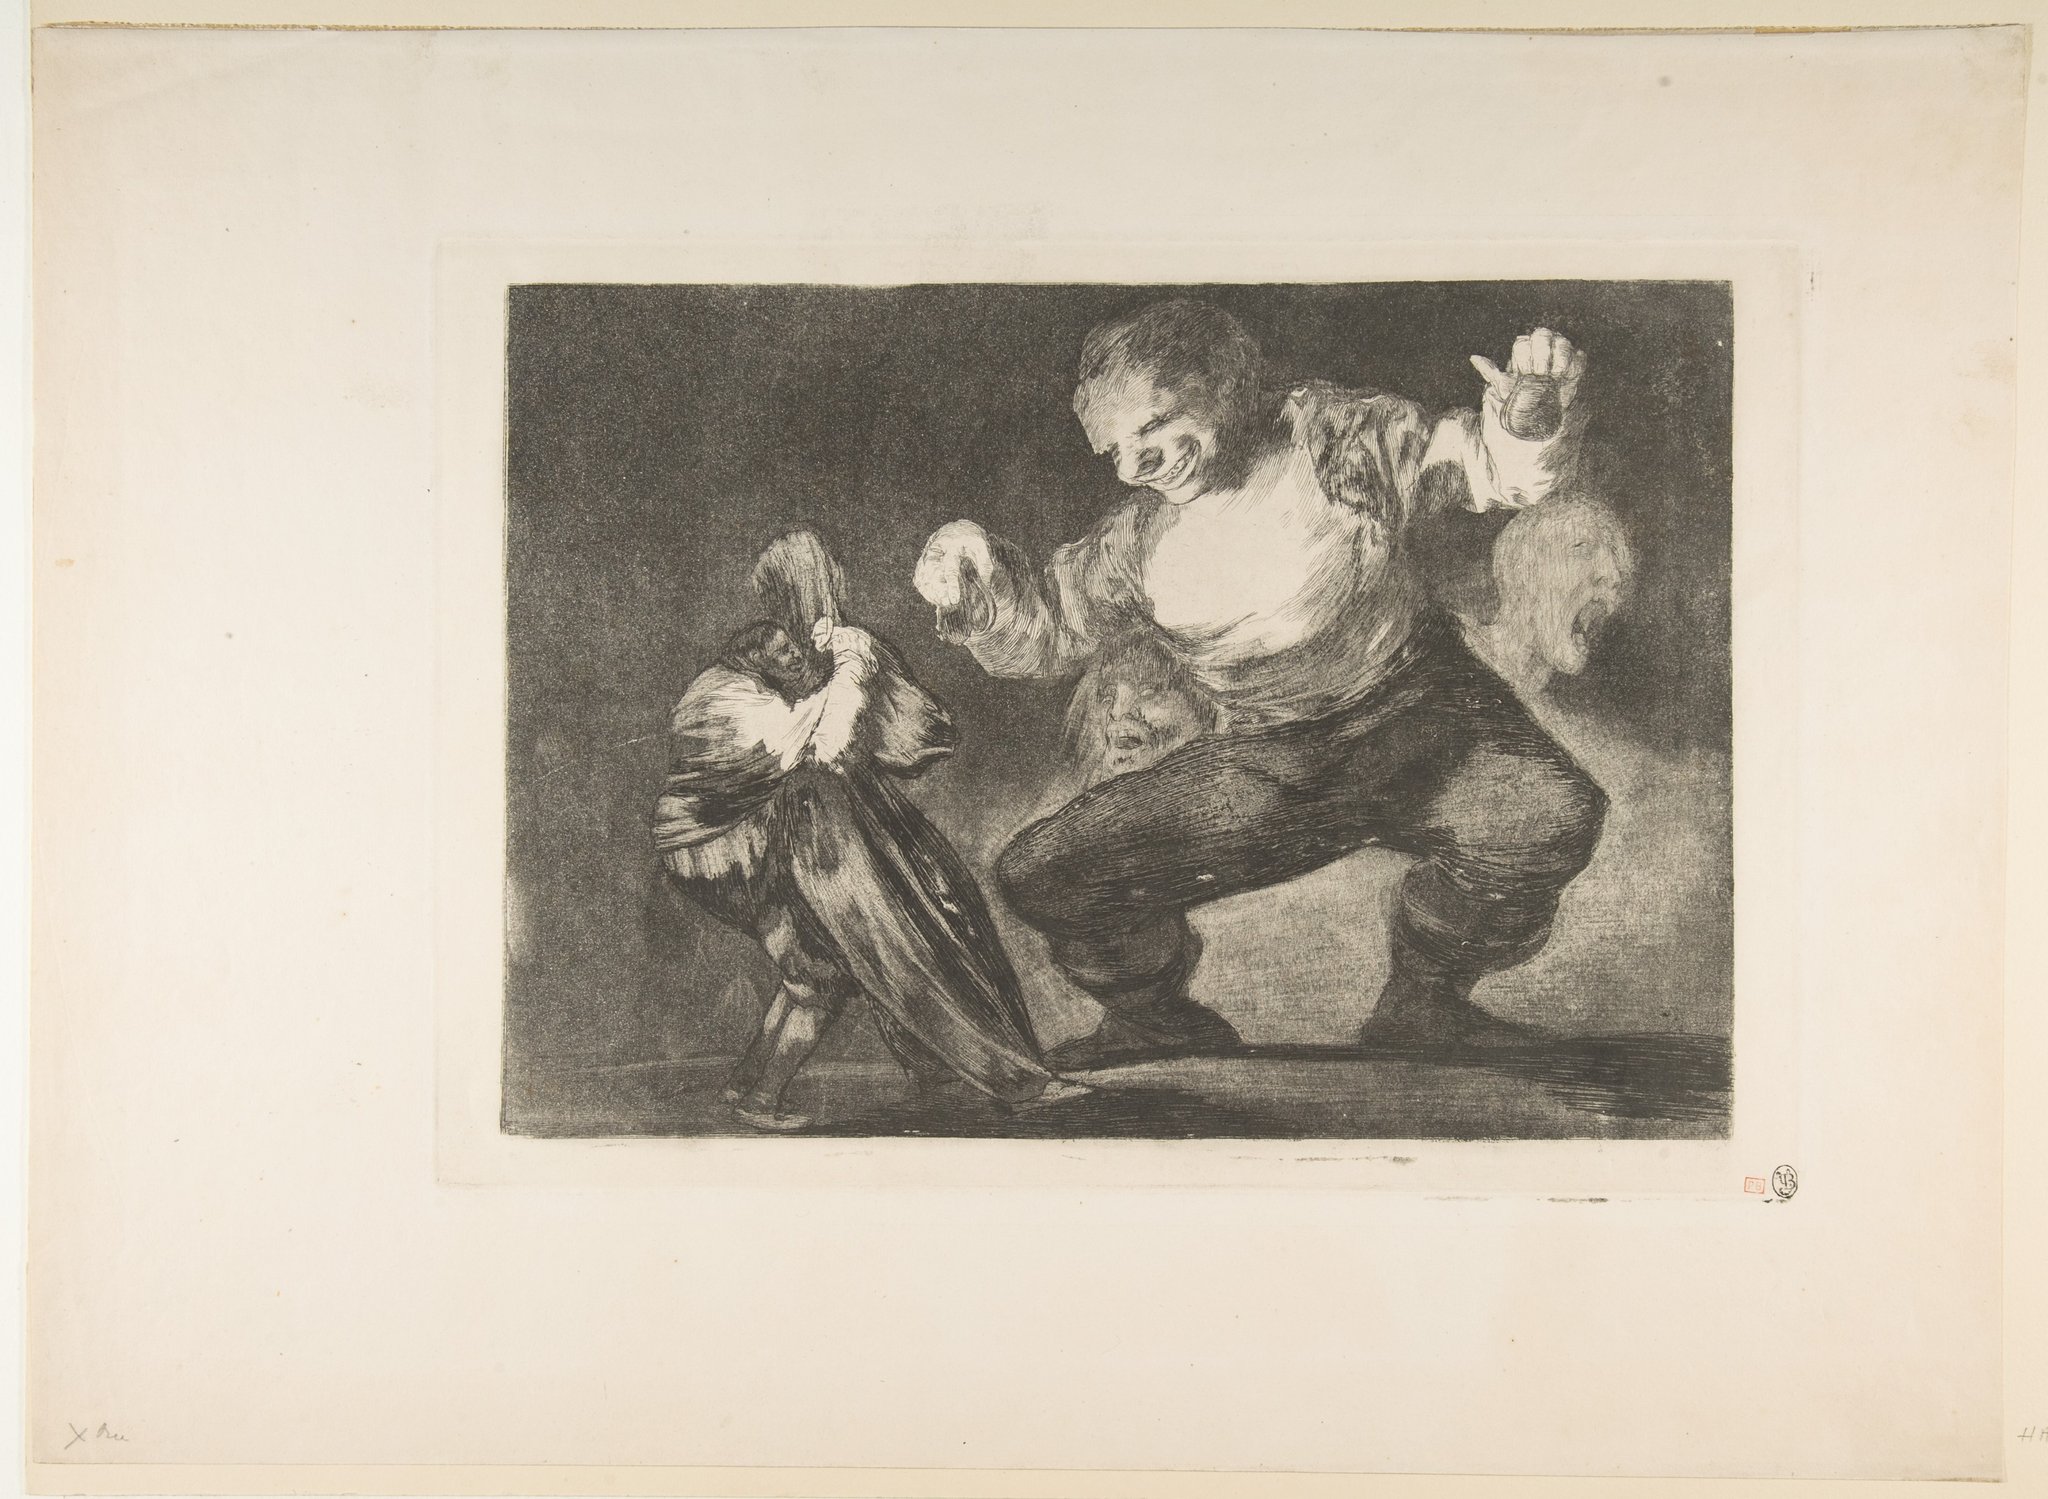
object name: print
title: 'Dancing Giant' from the 'Disparates' (Follies / Irrationalities)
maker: goya (francisco de goya y lucientes)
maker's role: artist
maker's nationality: spanish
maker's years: 1746-1828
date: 1815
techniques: aquatint, burnishing, drypoint, etching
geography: spain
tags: fear,men